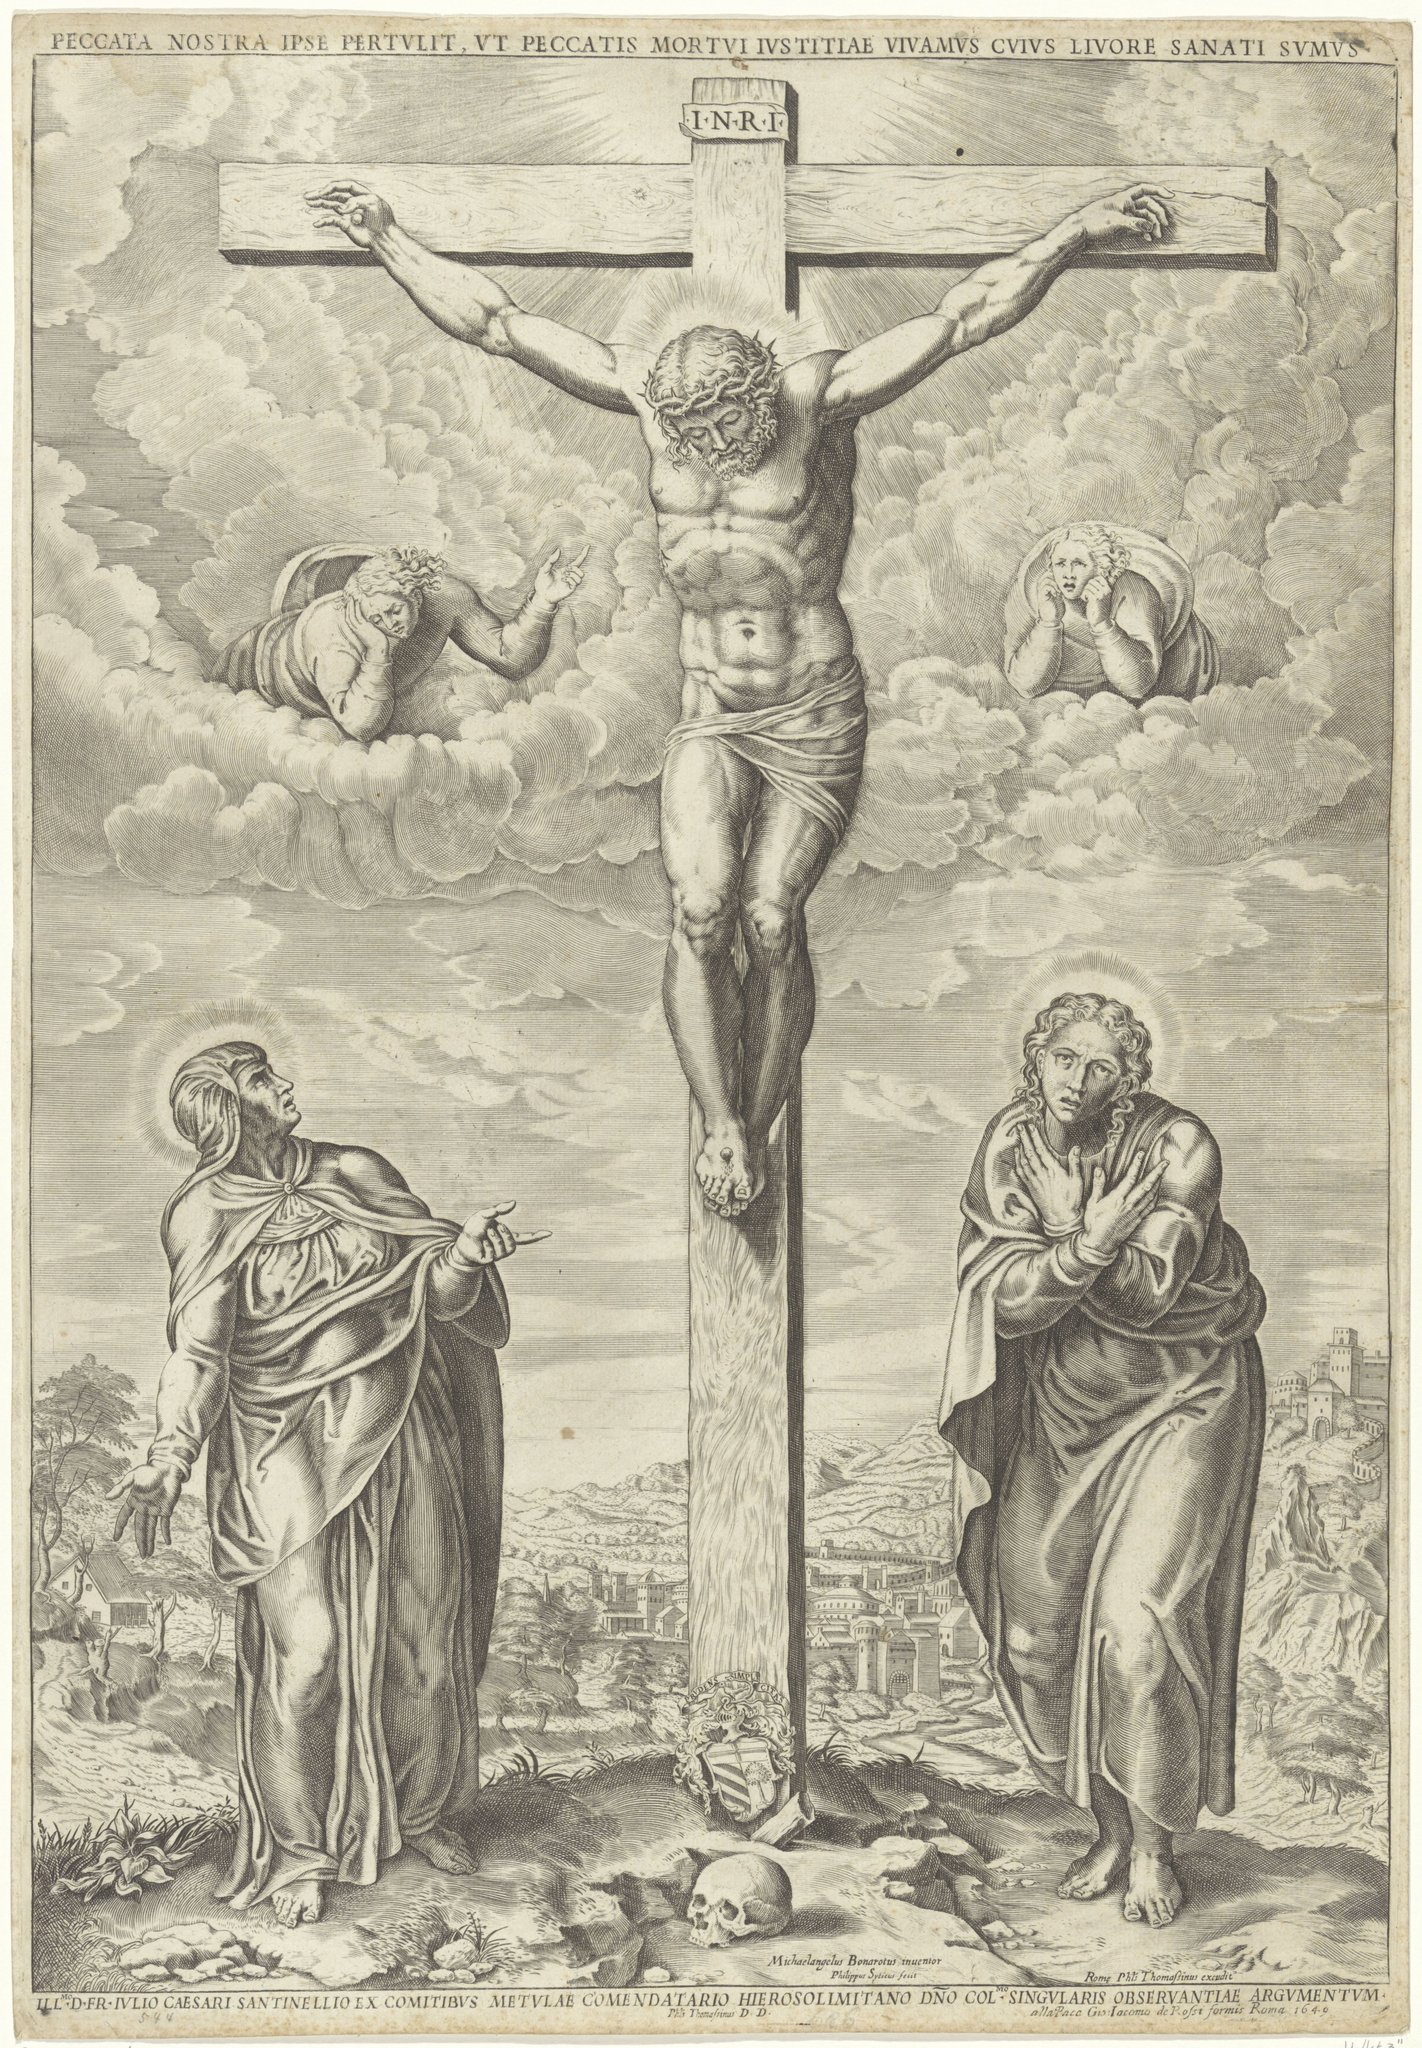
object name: print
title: Christus aan het kruis geflankeerd door Maria en Johannes in een landschap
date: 1566-1572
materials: paper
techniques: engraving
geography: rome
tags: crucified christ with mary and john on either side of the cross; holy rood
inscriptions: collector's mark: Lugt 2228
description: Landschap met Christus aan het kruis geflankeerd door Maria en Johannes. Op de wolken twee treurende engelen. Boven en onder de voorstelling een regel tekst in het Latijn.